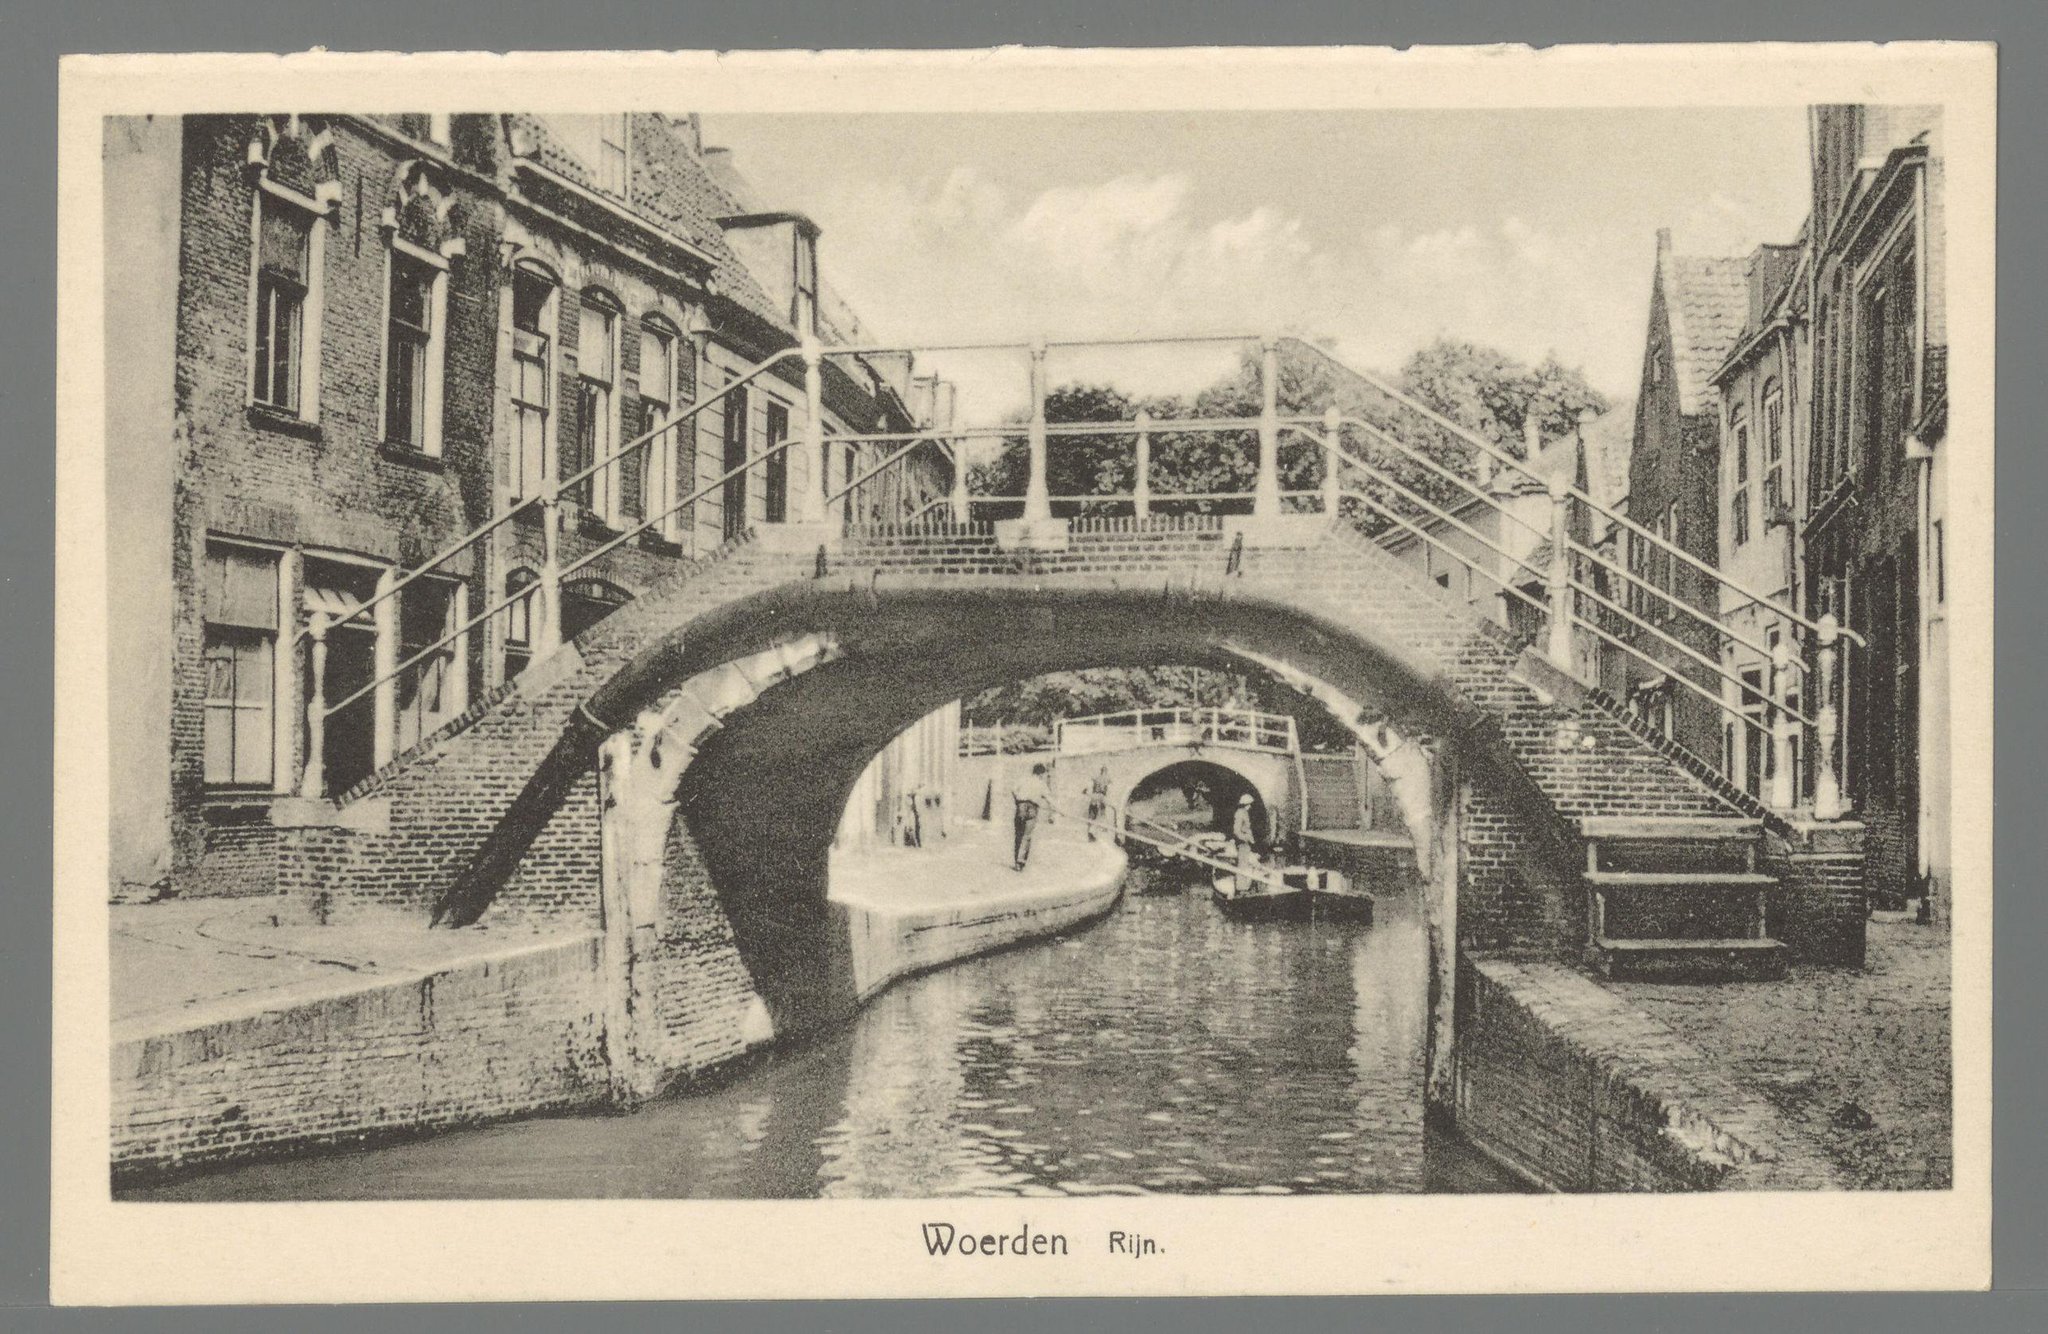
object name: photomechanical print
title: Woerden. Rijn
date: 1925-1950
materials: cardboard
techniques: photograph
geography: woerden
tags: canals, waters (in city), bridge in city across river, canal, etc., street